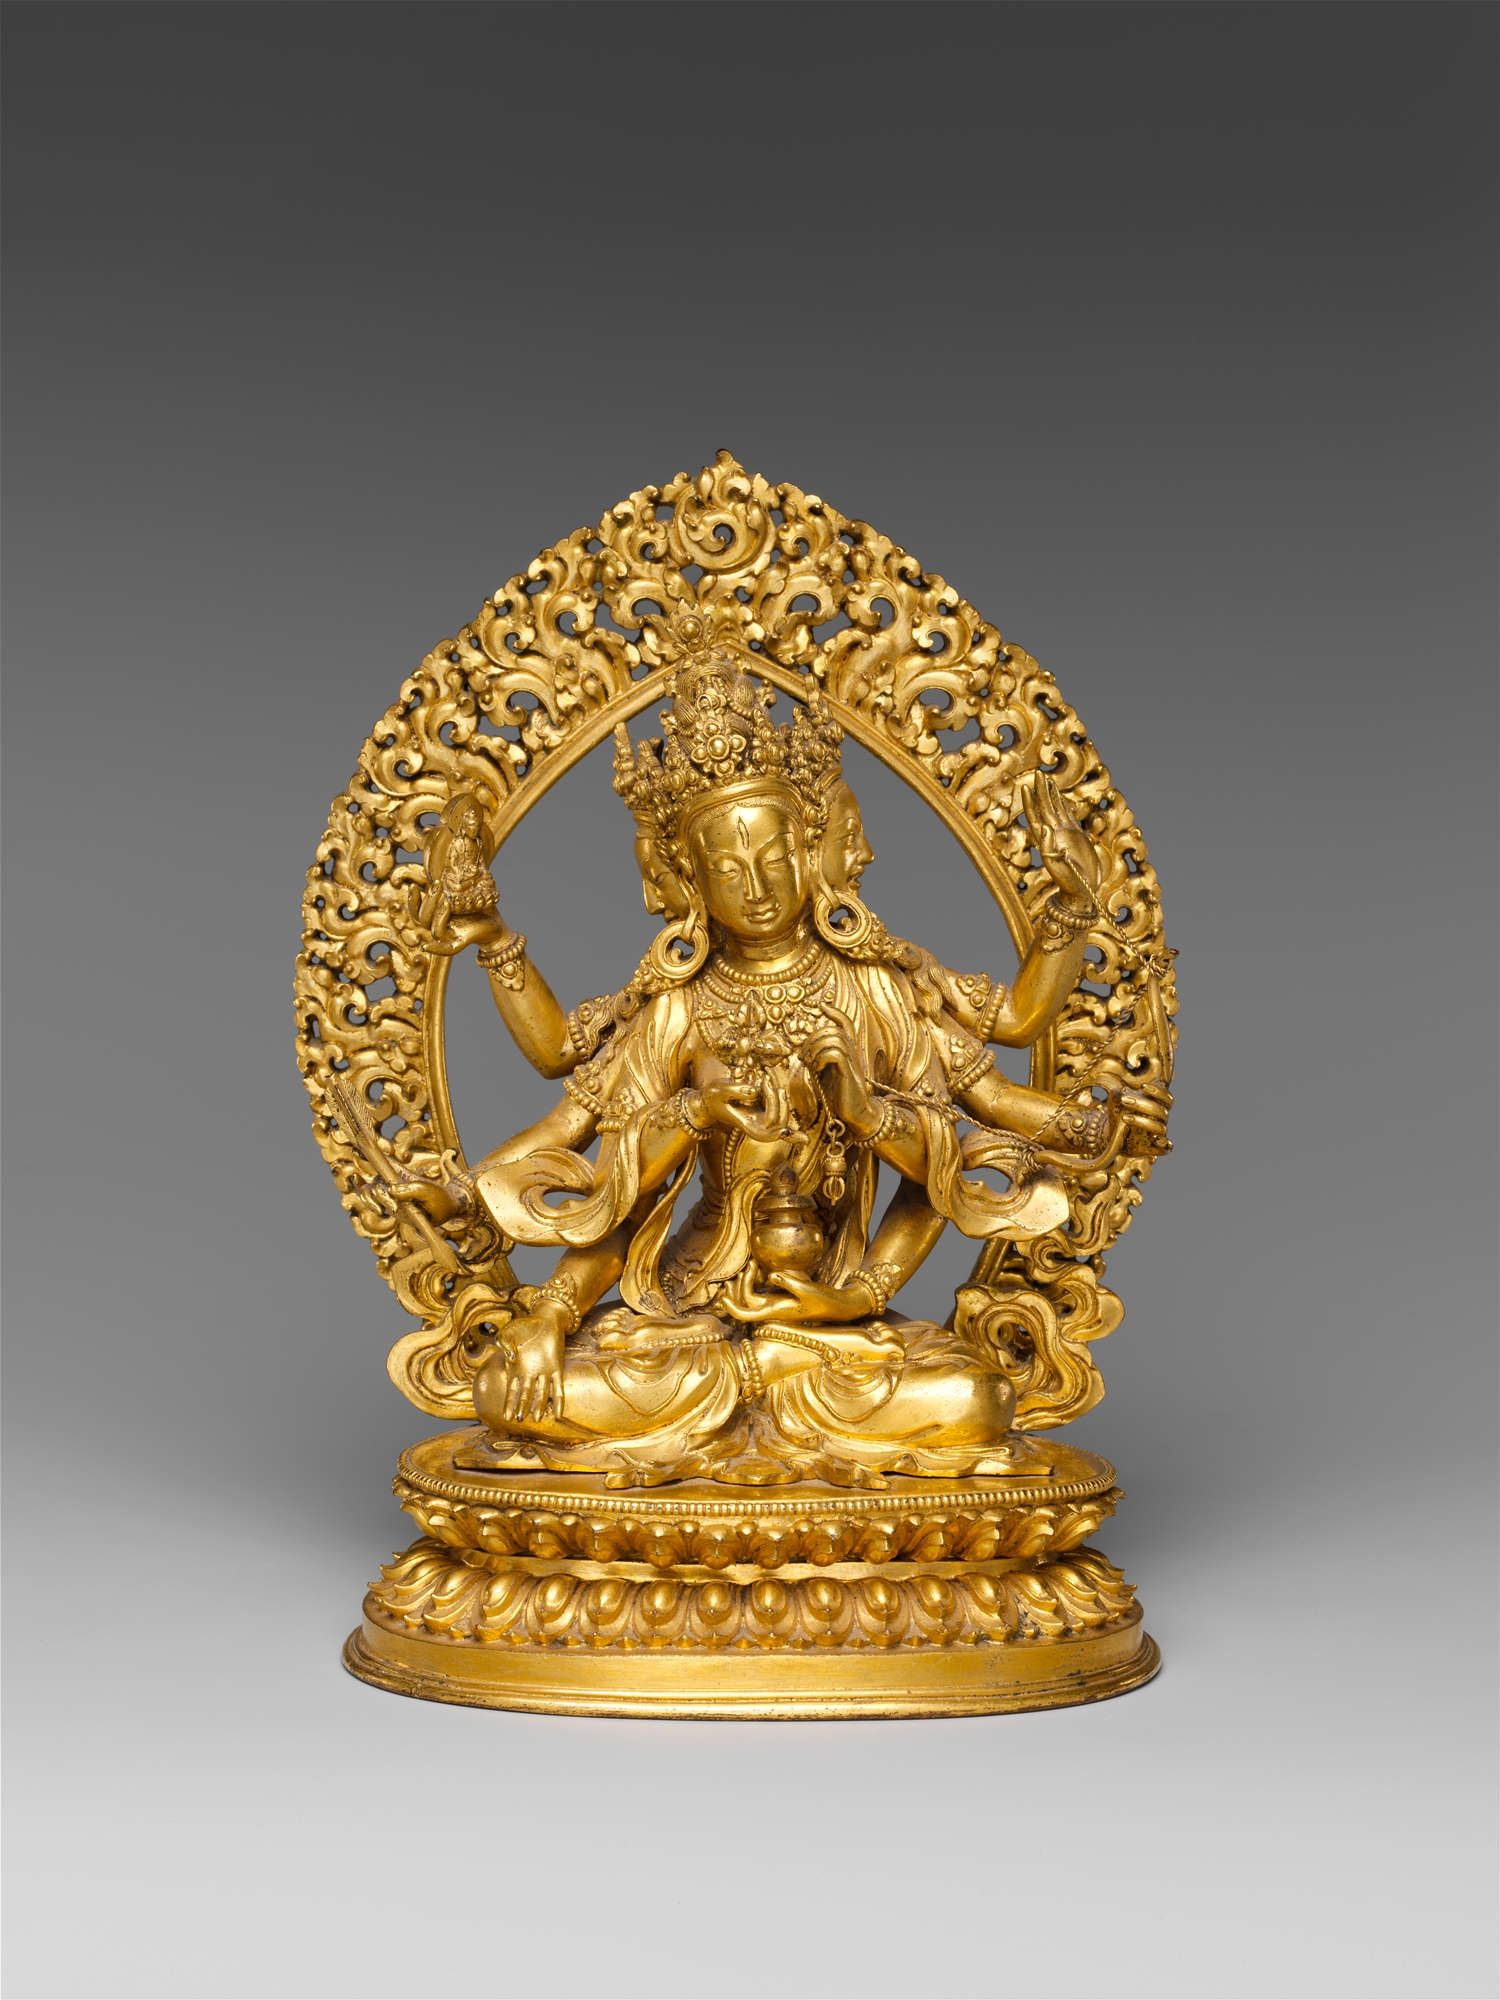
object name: figure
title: Buddhist Deity, Ushnishavijaya (Zun Sheng fo mu)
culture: chinese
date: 1667-1800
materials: brass, gilt, wax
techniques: casting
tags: bow and arrow,buddhism,deities